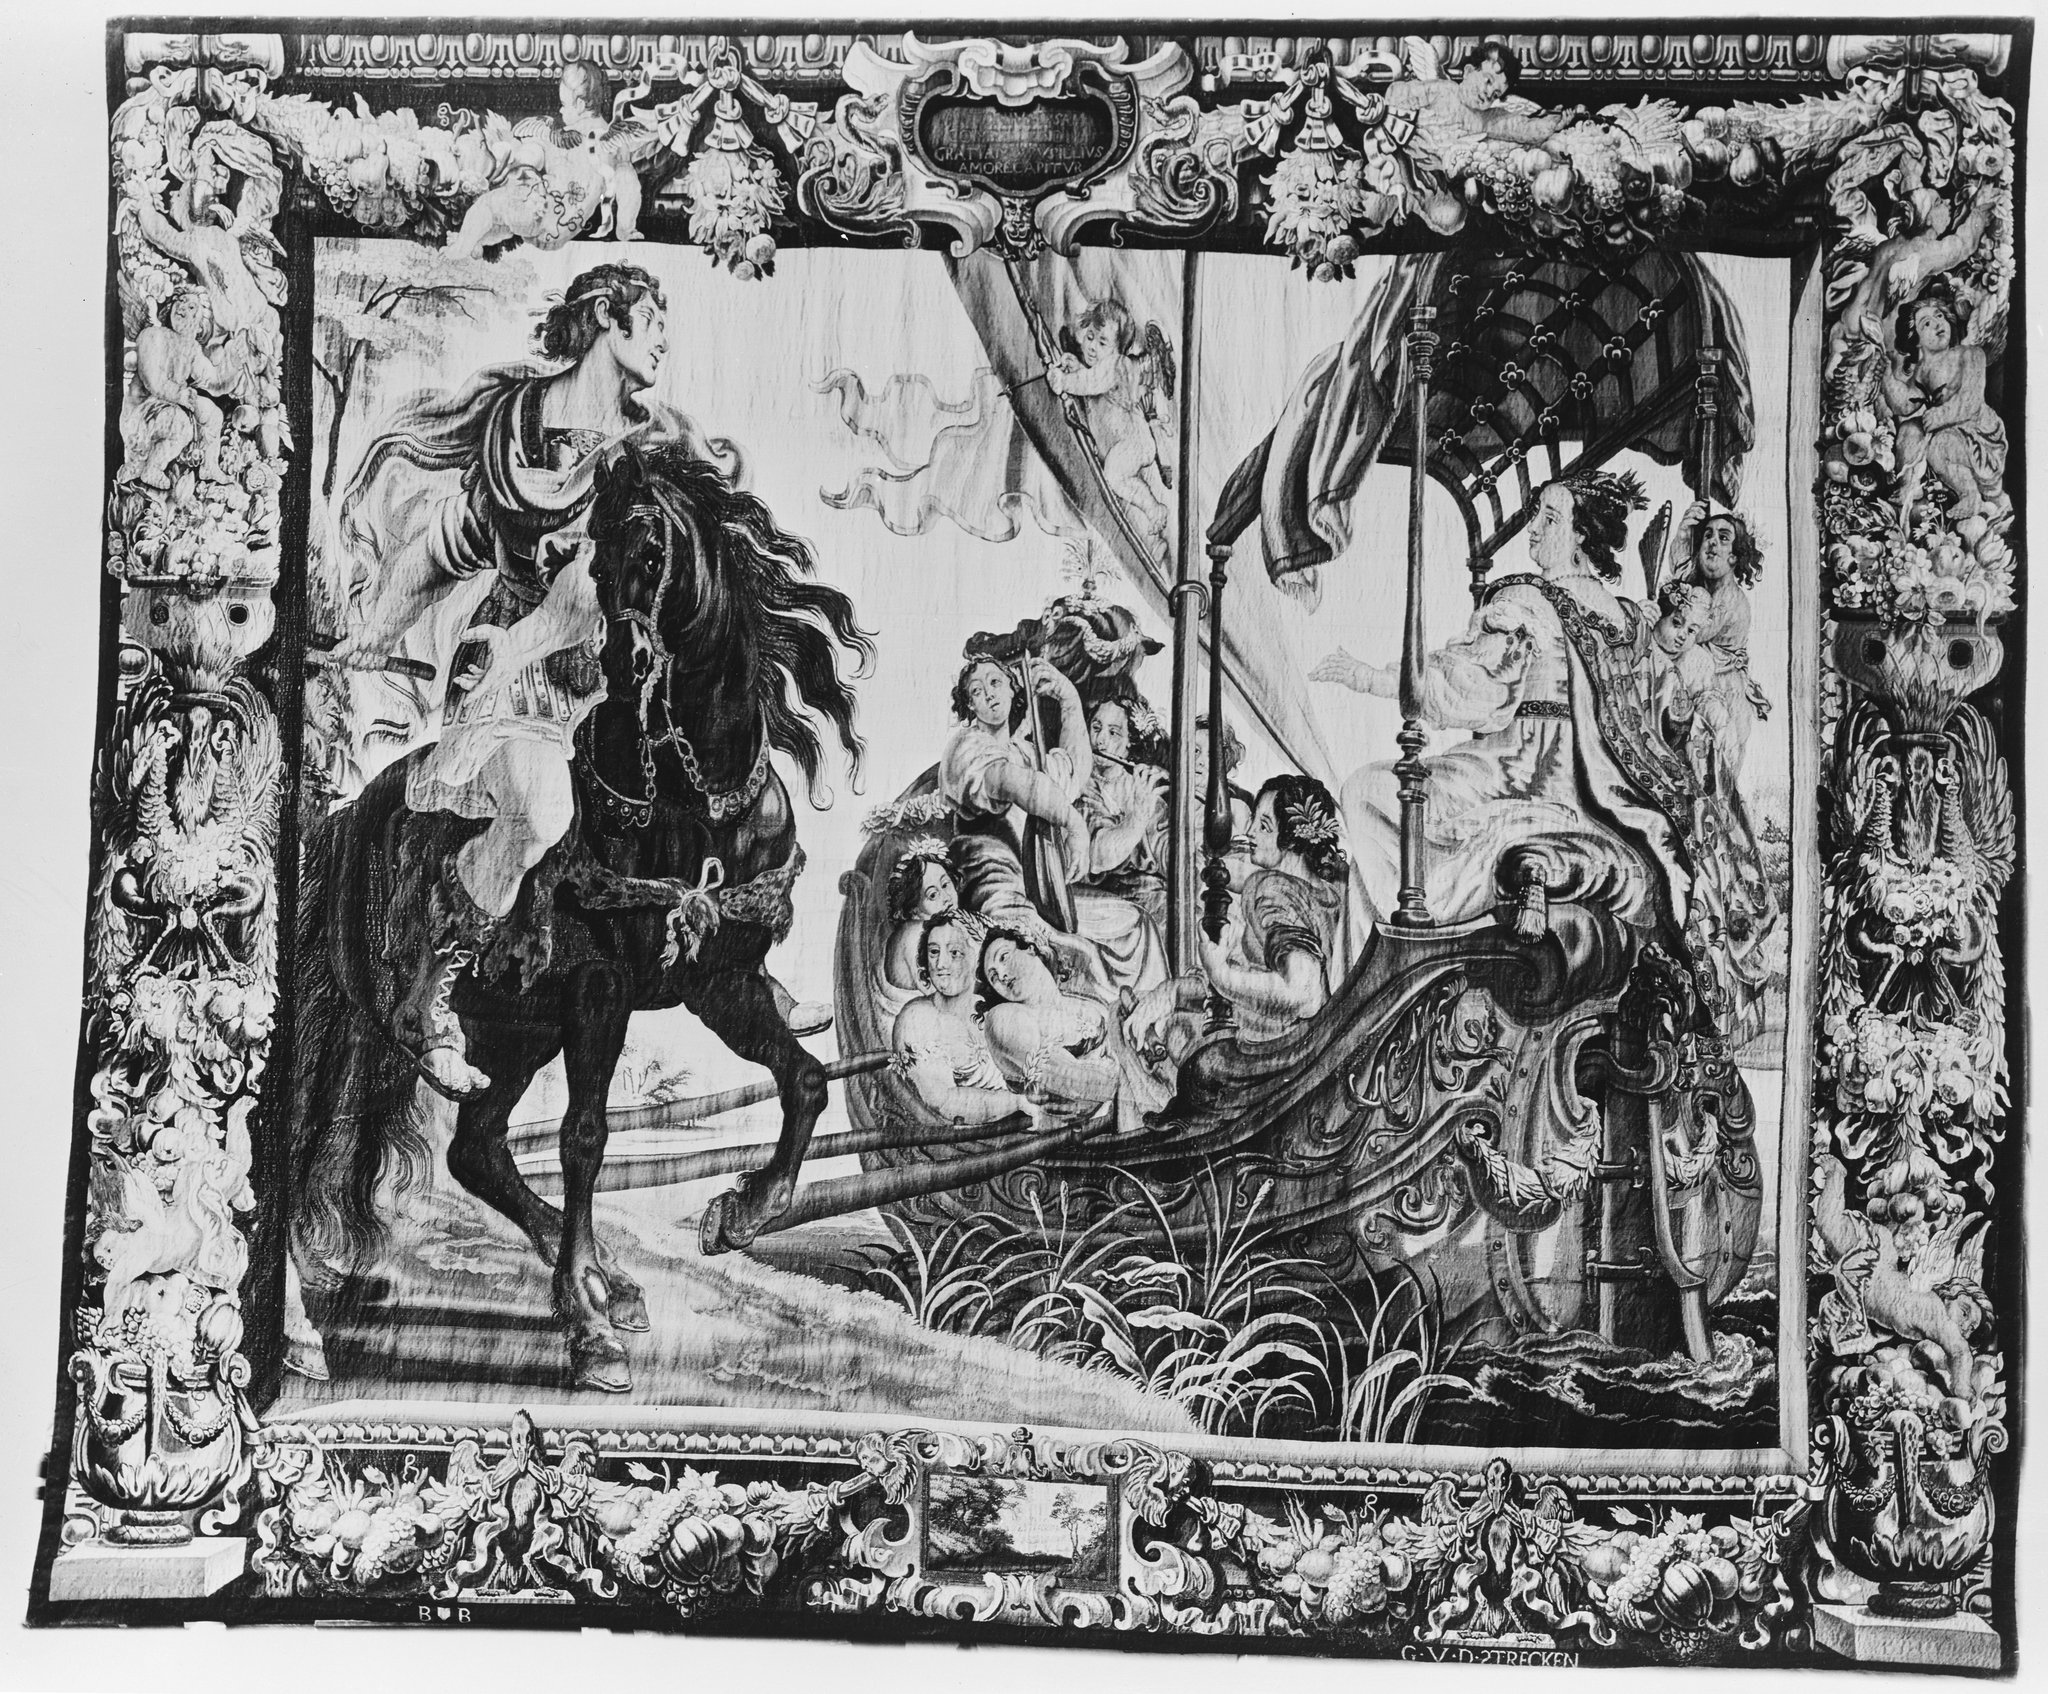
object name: tapestry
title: The Meeting of Antony and Cleopatra from a set of The Story of Antony and Cleopatra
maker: justus van egmont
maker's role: designer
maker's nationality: flemish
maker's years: 1601-1674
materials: silk, silver, silver gilt, thread, wool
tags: cleopatra,mark antony,women,horses,boats